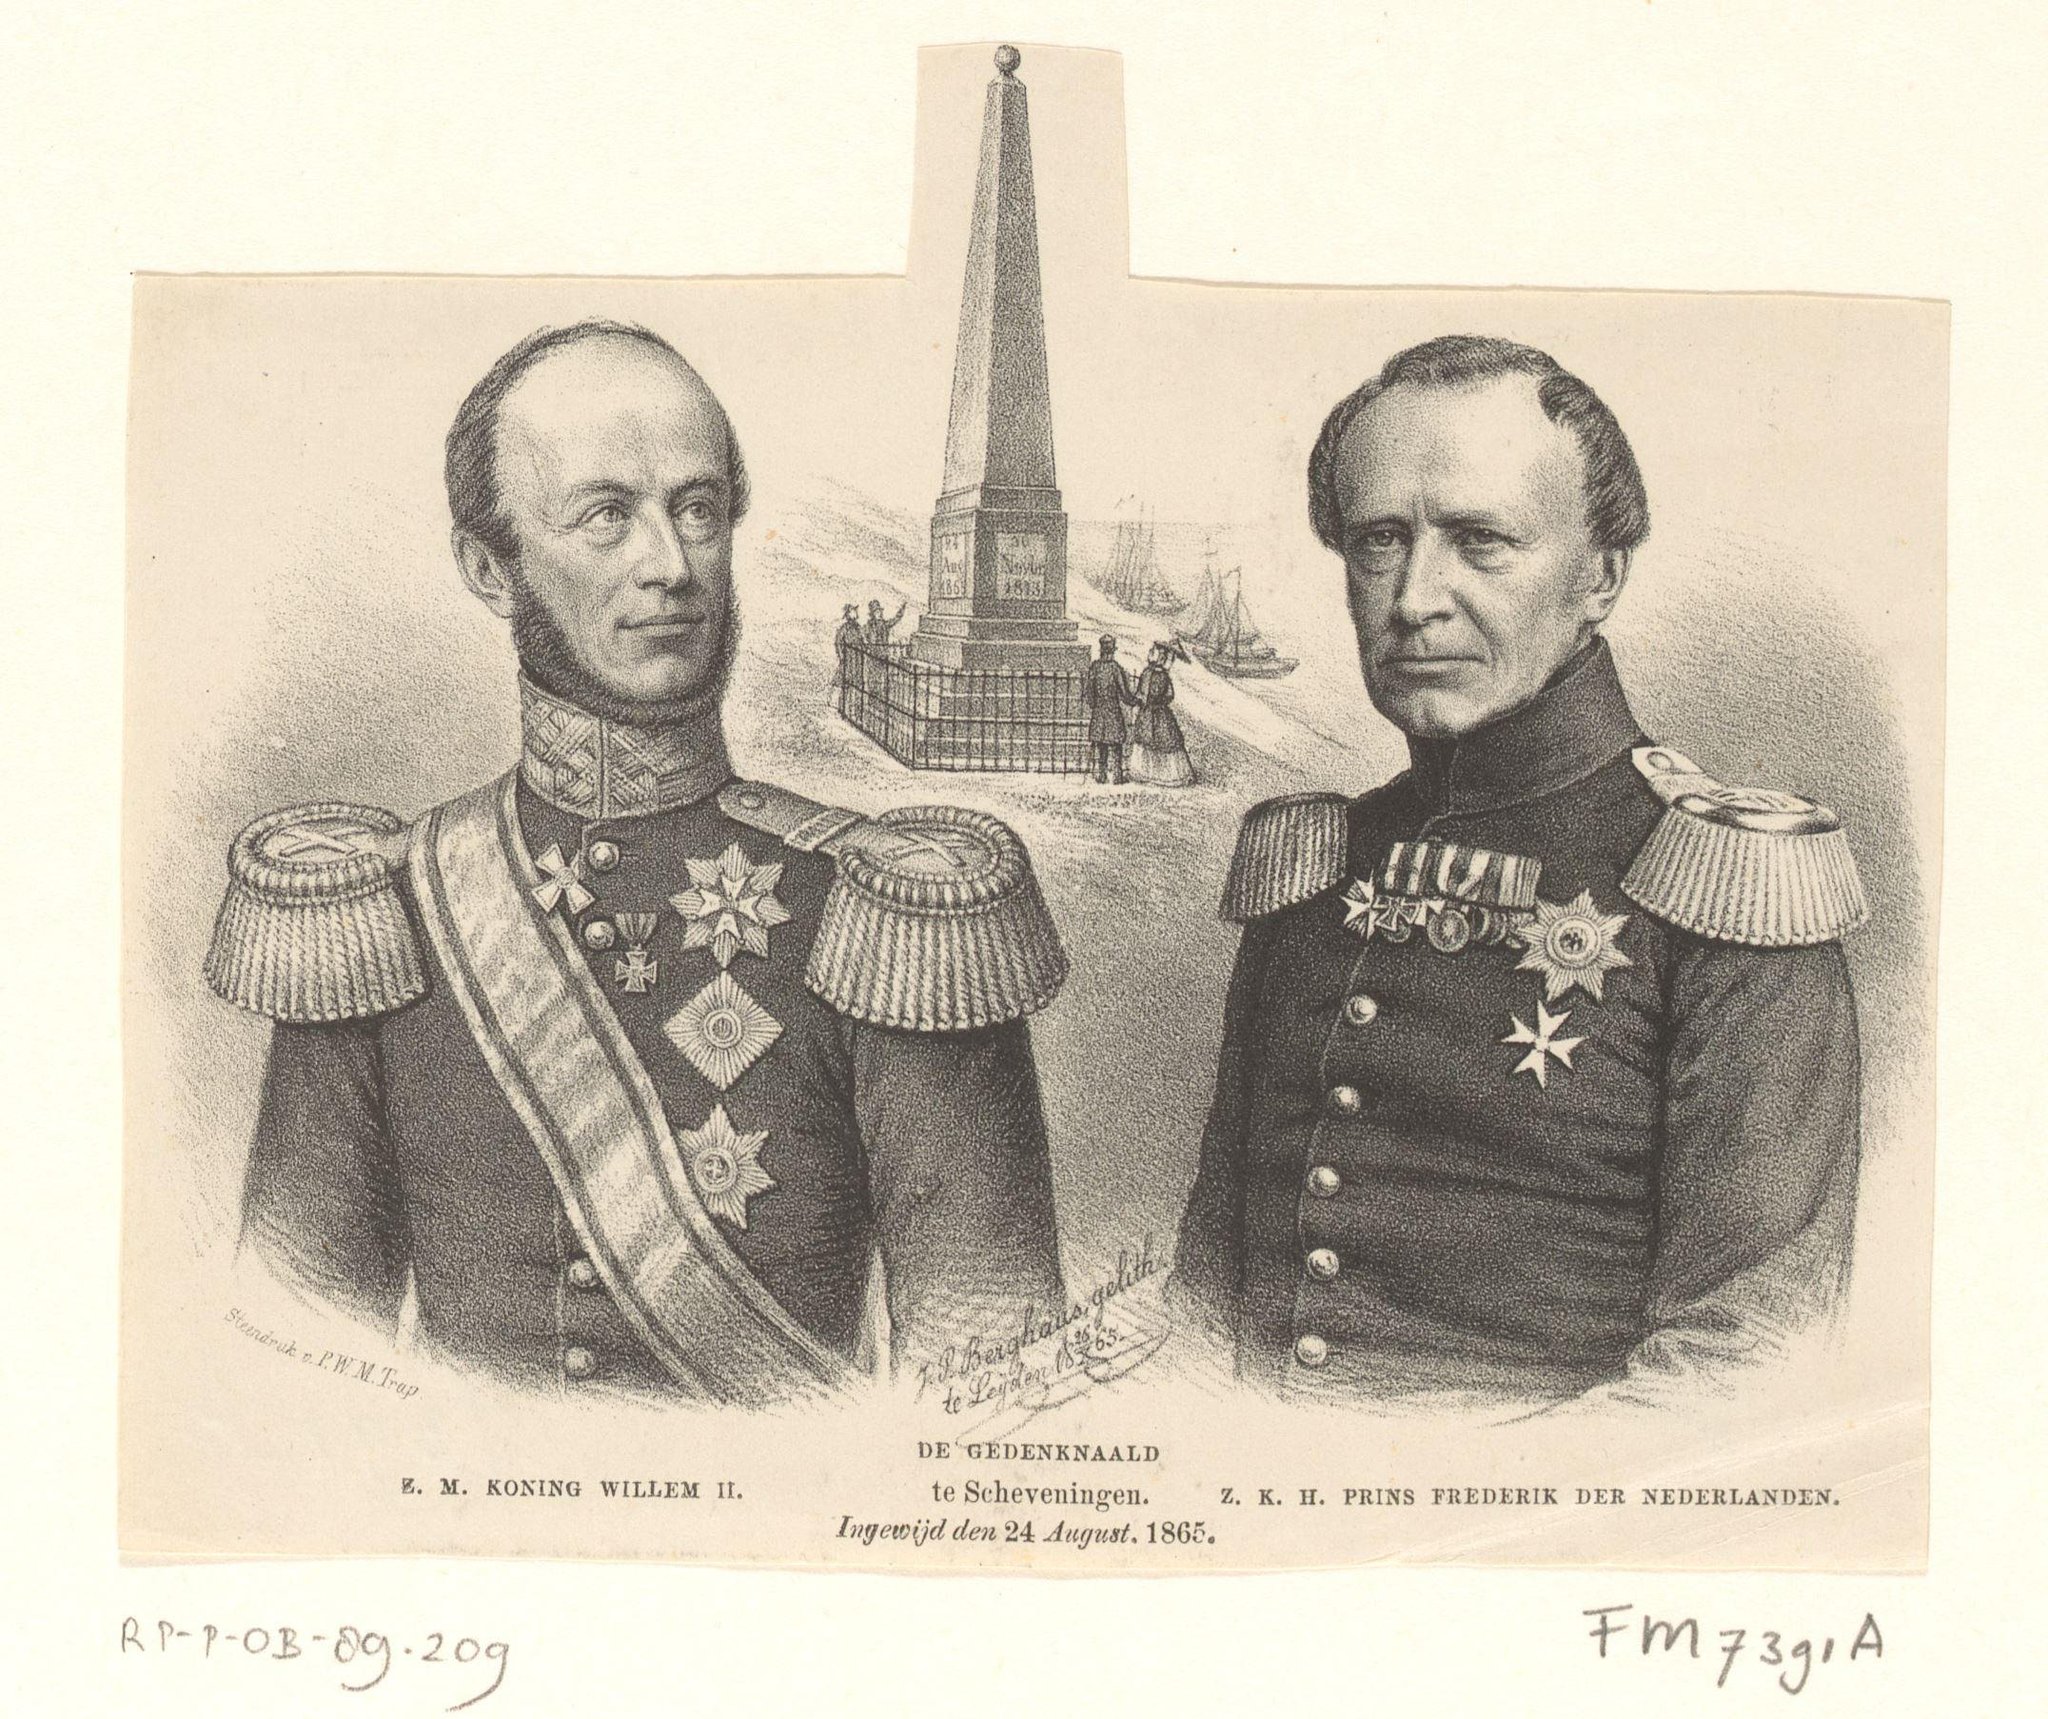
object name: print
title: De Gedenknaald te Scheveningen. Ingewijd den 24 August. 1865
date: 1865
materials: paper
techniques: lithograph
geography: leiden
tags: the hague, william ii of the netherlands, berlin, frederik (prins der nederlanden), monument, statue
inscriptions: collector's mark: Lugt 2228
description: Portretten van koning Willem II en Prins Frederik met tussen hen in de gedenknaald te Scheveningen op de plaats waar vandaan stadhouder Willem V naar Engeland is vertrokken op 18 januari 1795 en waar koning Willem I in 1813 is teruggekeerd. Monument onthuld op 24 augustus 1865.